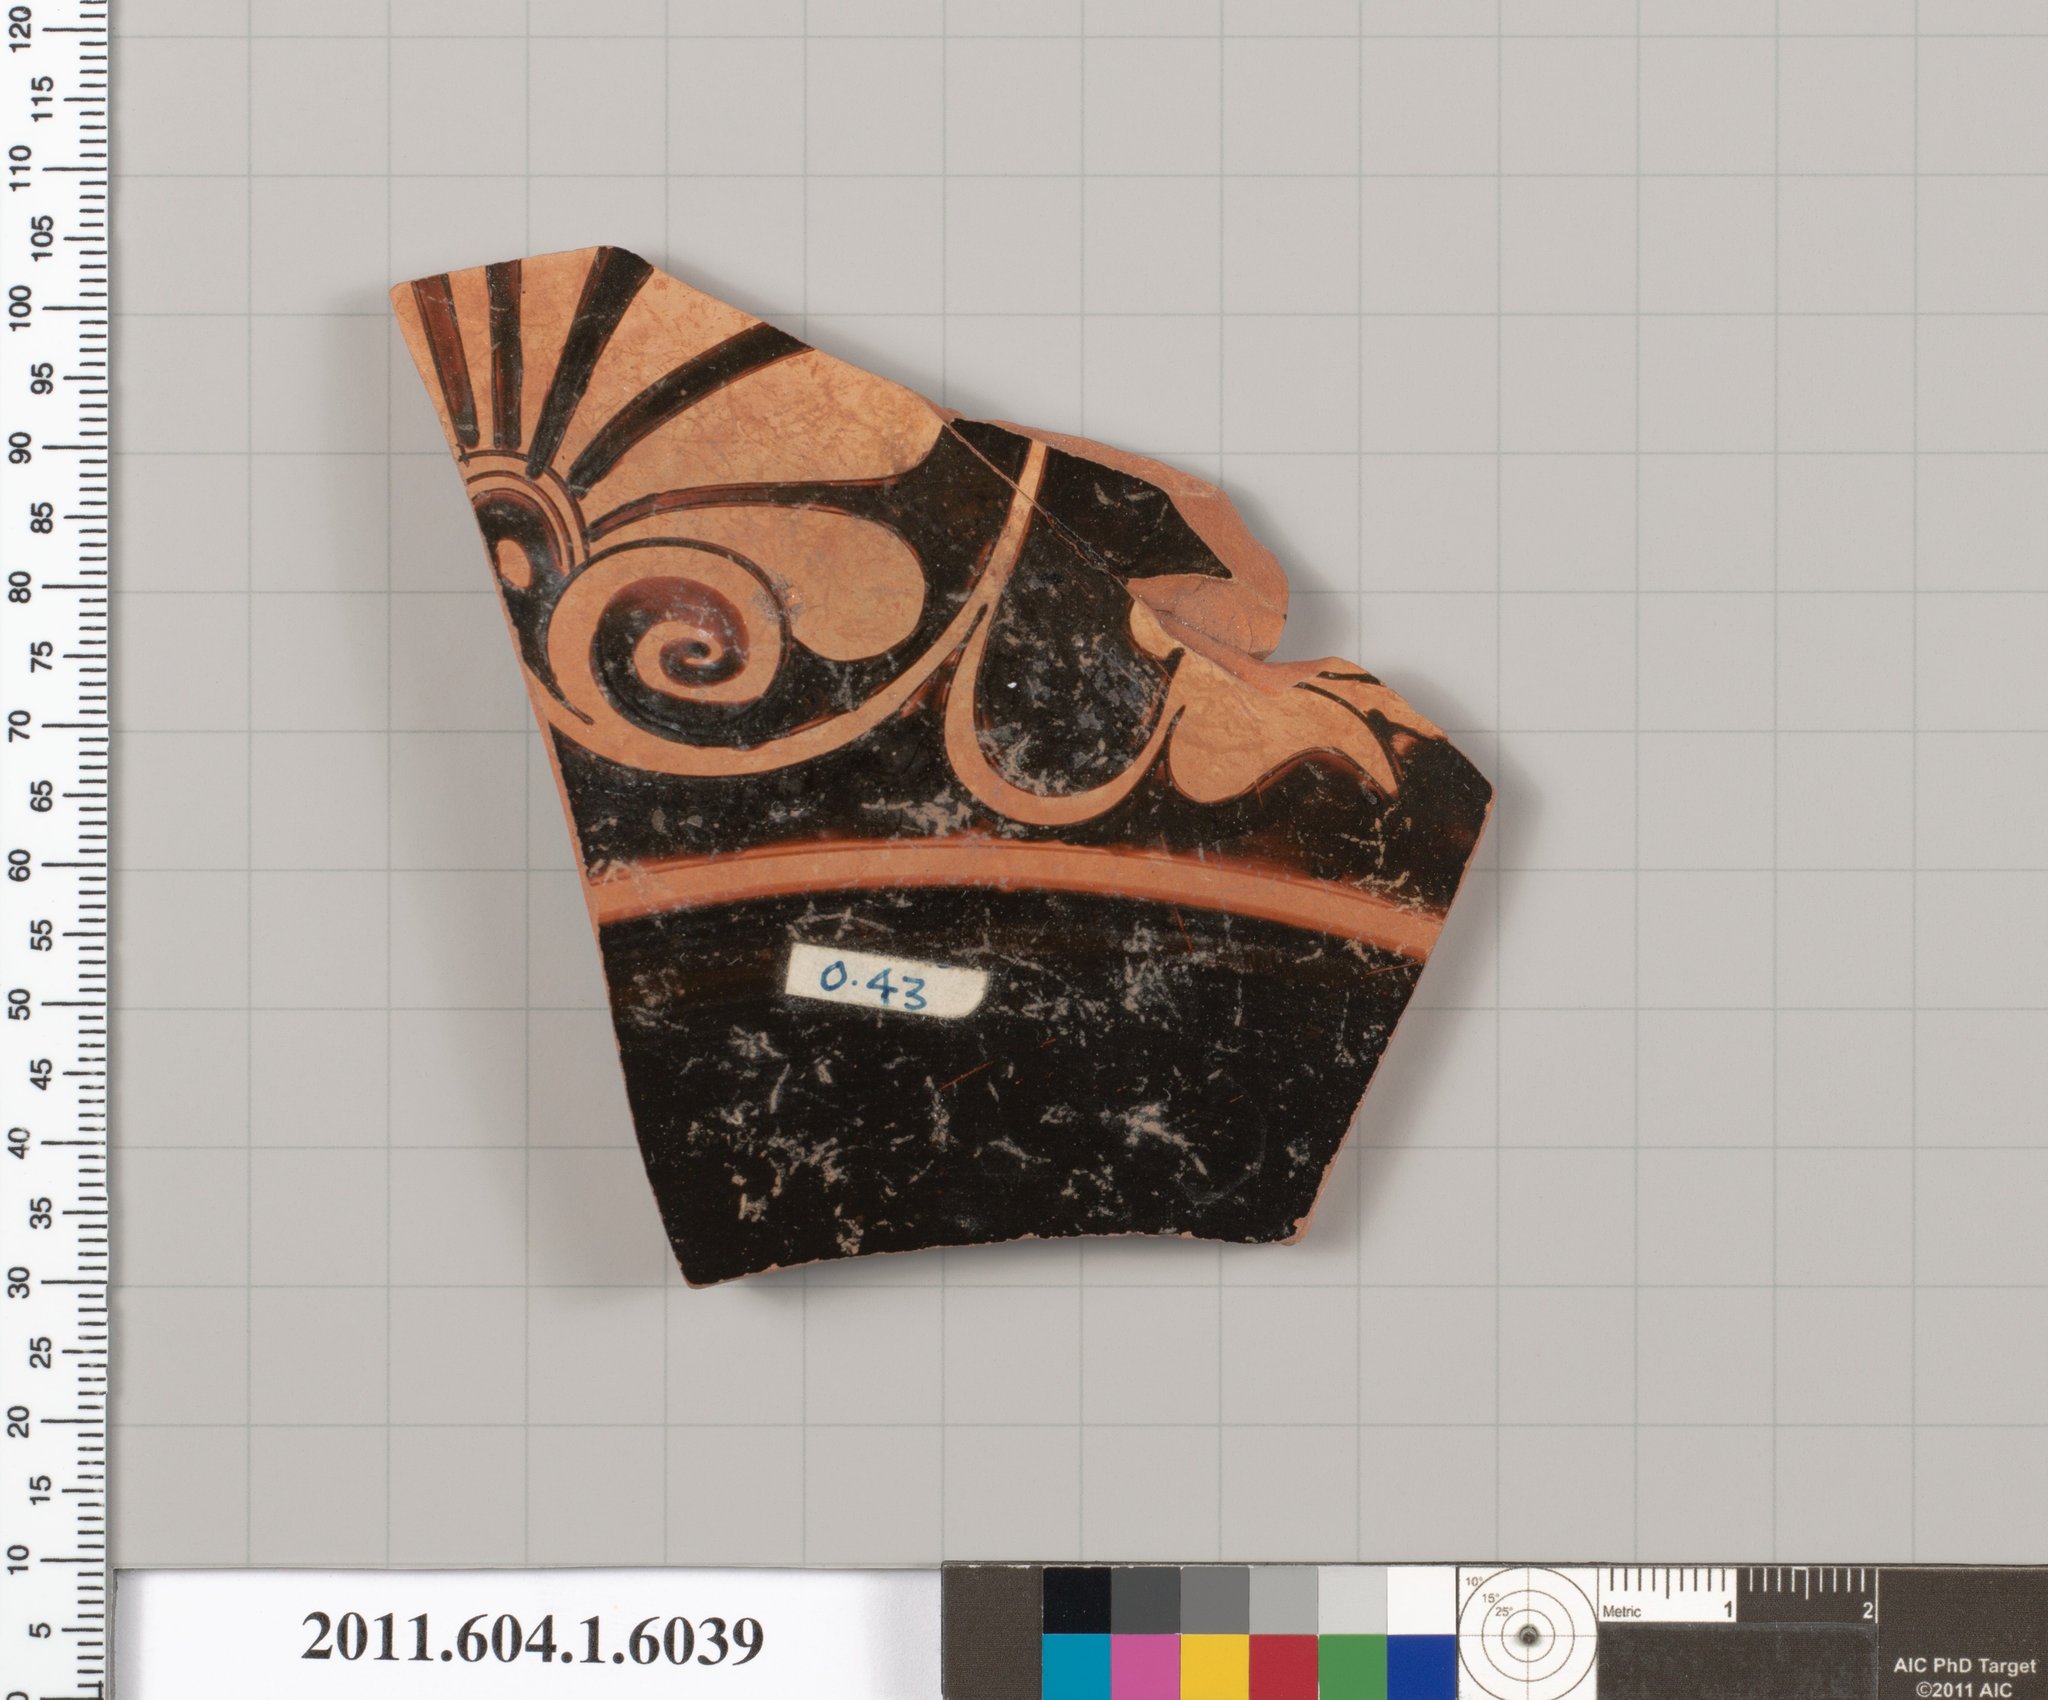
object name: kylix fragment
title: Terracotta rim fragment of a kylix (drinking cup)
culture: greek, attic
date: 510-500 BCE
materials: terracotta